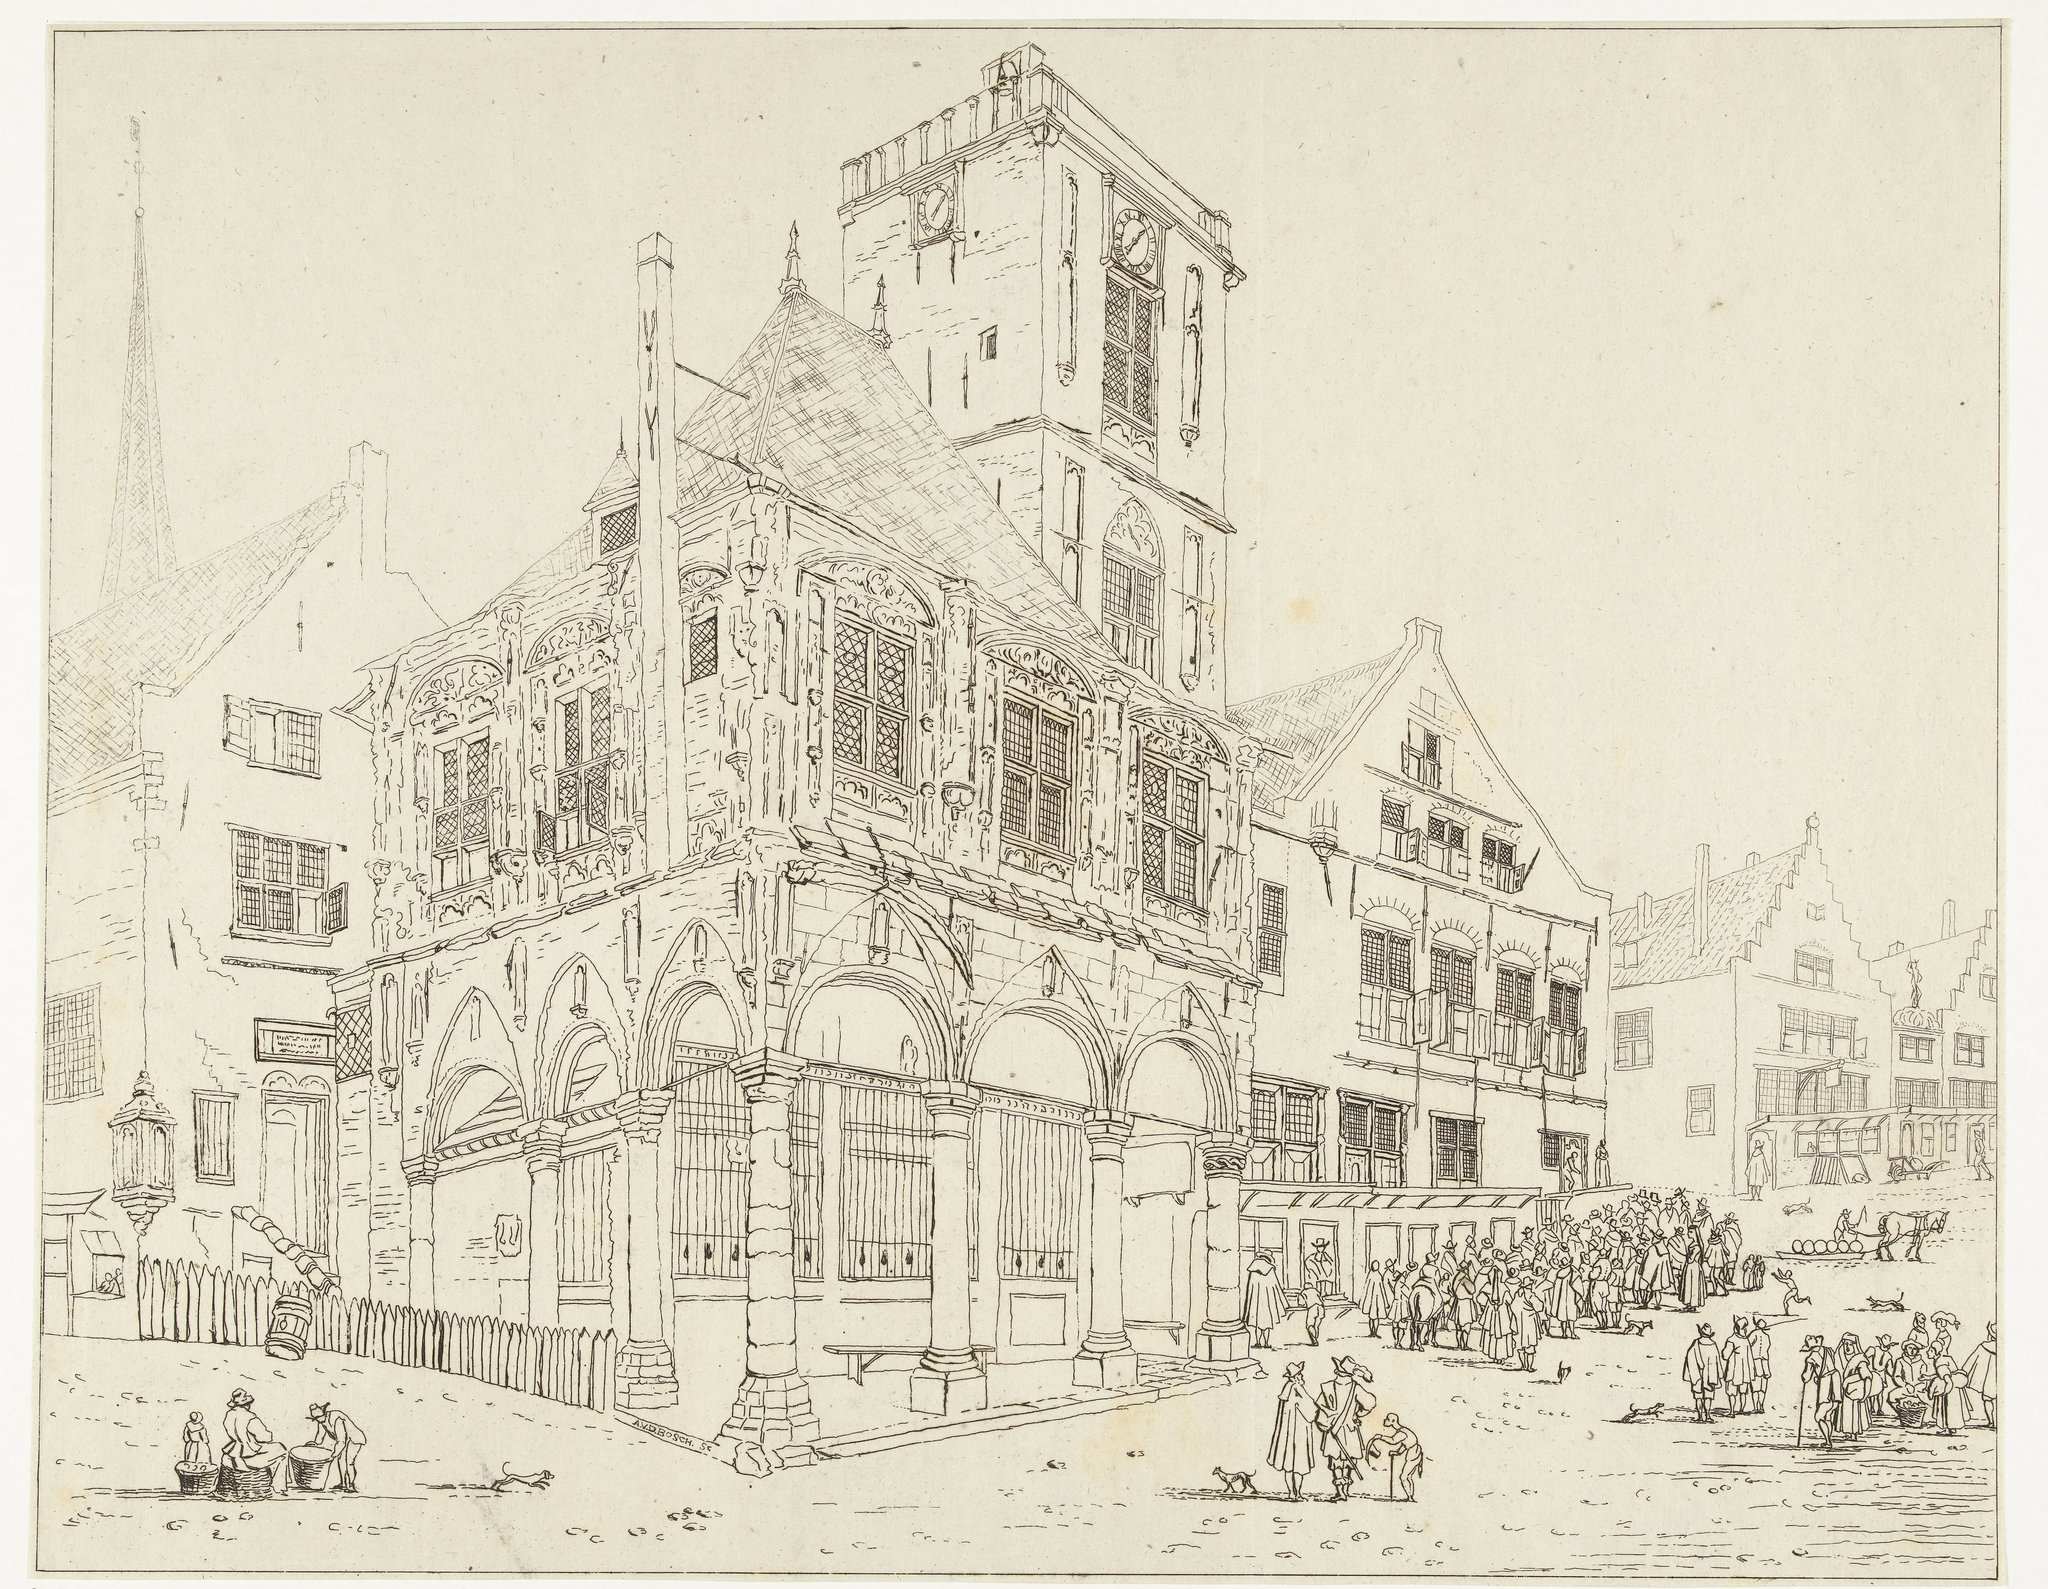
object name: print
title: Het Oude Stadhuis van Amsterdam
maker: anthonie van den bos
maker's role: draughtsman, print maker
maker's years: 1763-1838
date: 1778-1838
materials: paper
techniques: etching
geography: netherlands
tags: the (nude) human figure; 'corpo humano' (ripa) (+ begging)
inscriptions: collector's mark: Lugt 2228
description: Het Oude Stadhuis van Amsterdam, voor de verwoesting door de grote brand van 1652. Een groep mensen staat te wachten voor een zijgebouw. Op de voorgrond worden twee mannen aangesproken door een bedelaar.